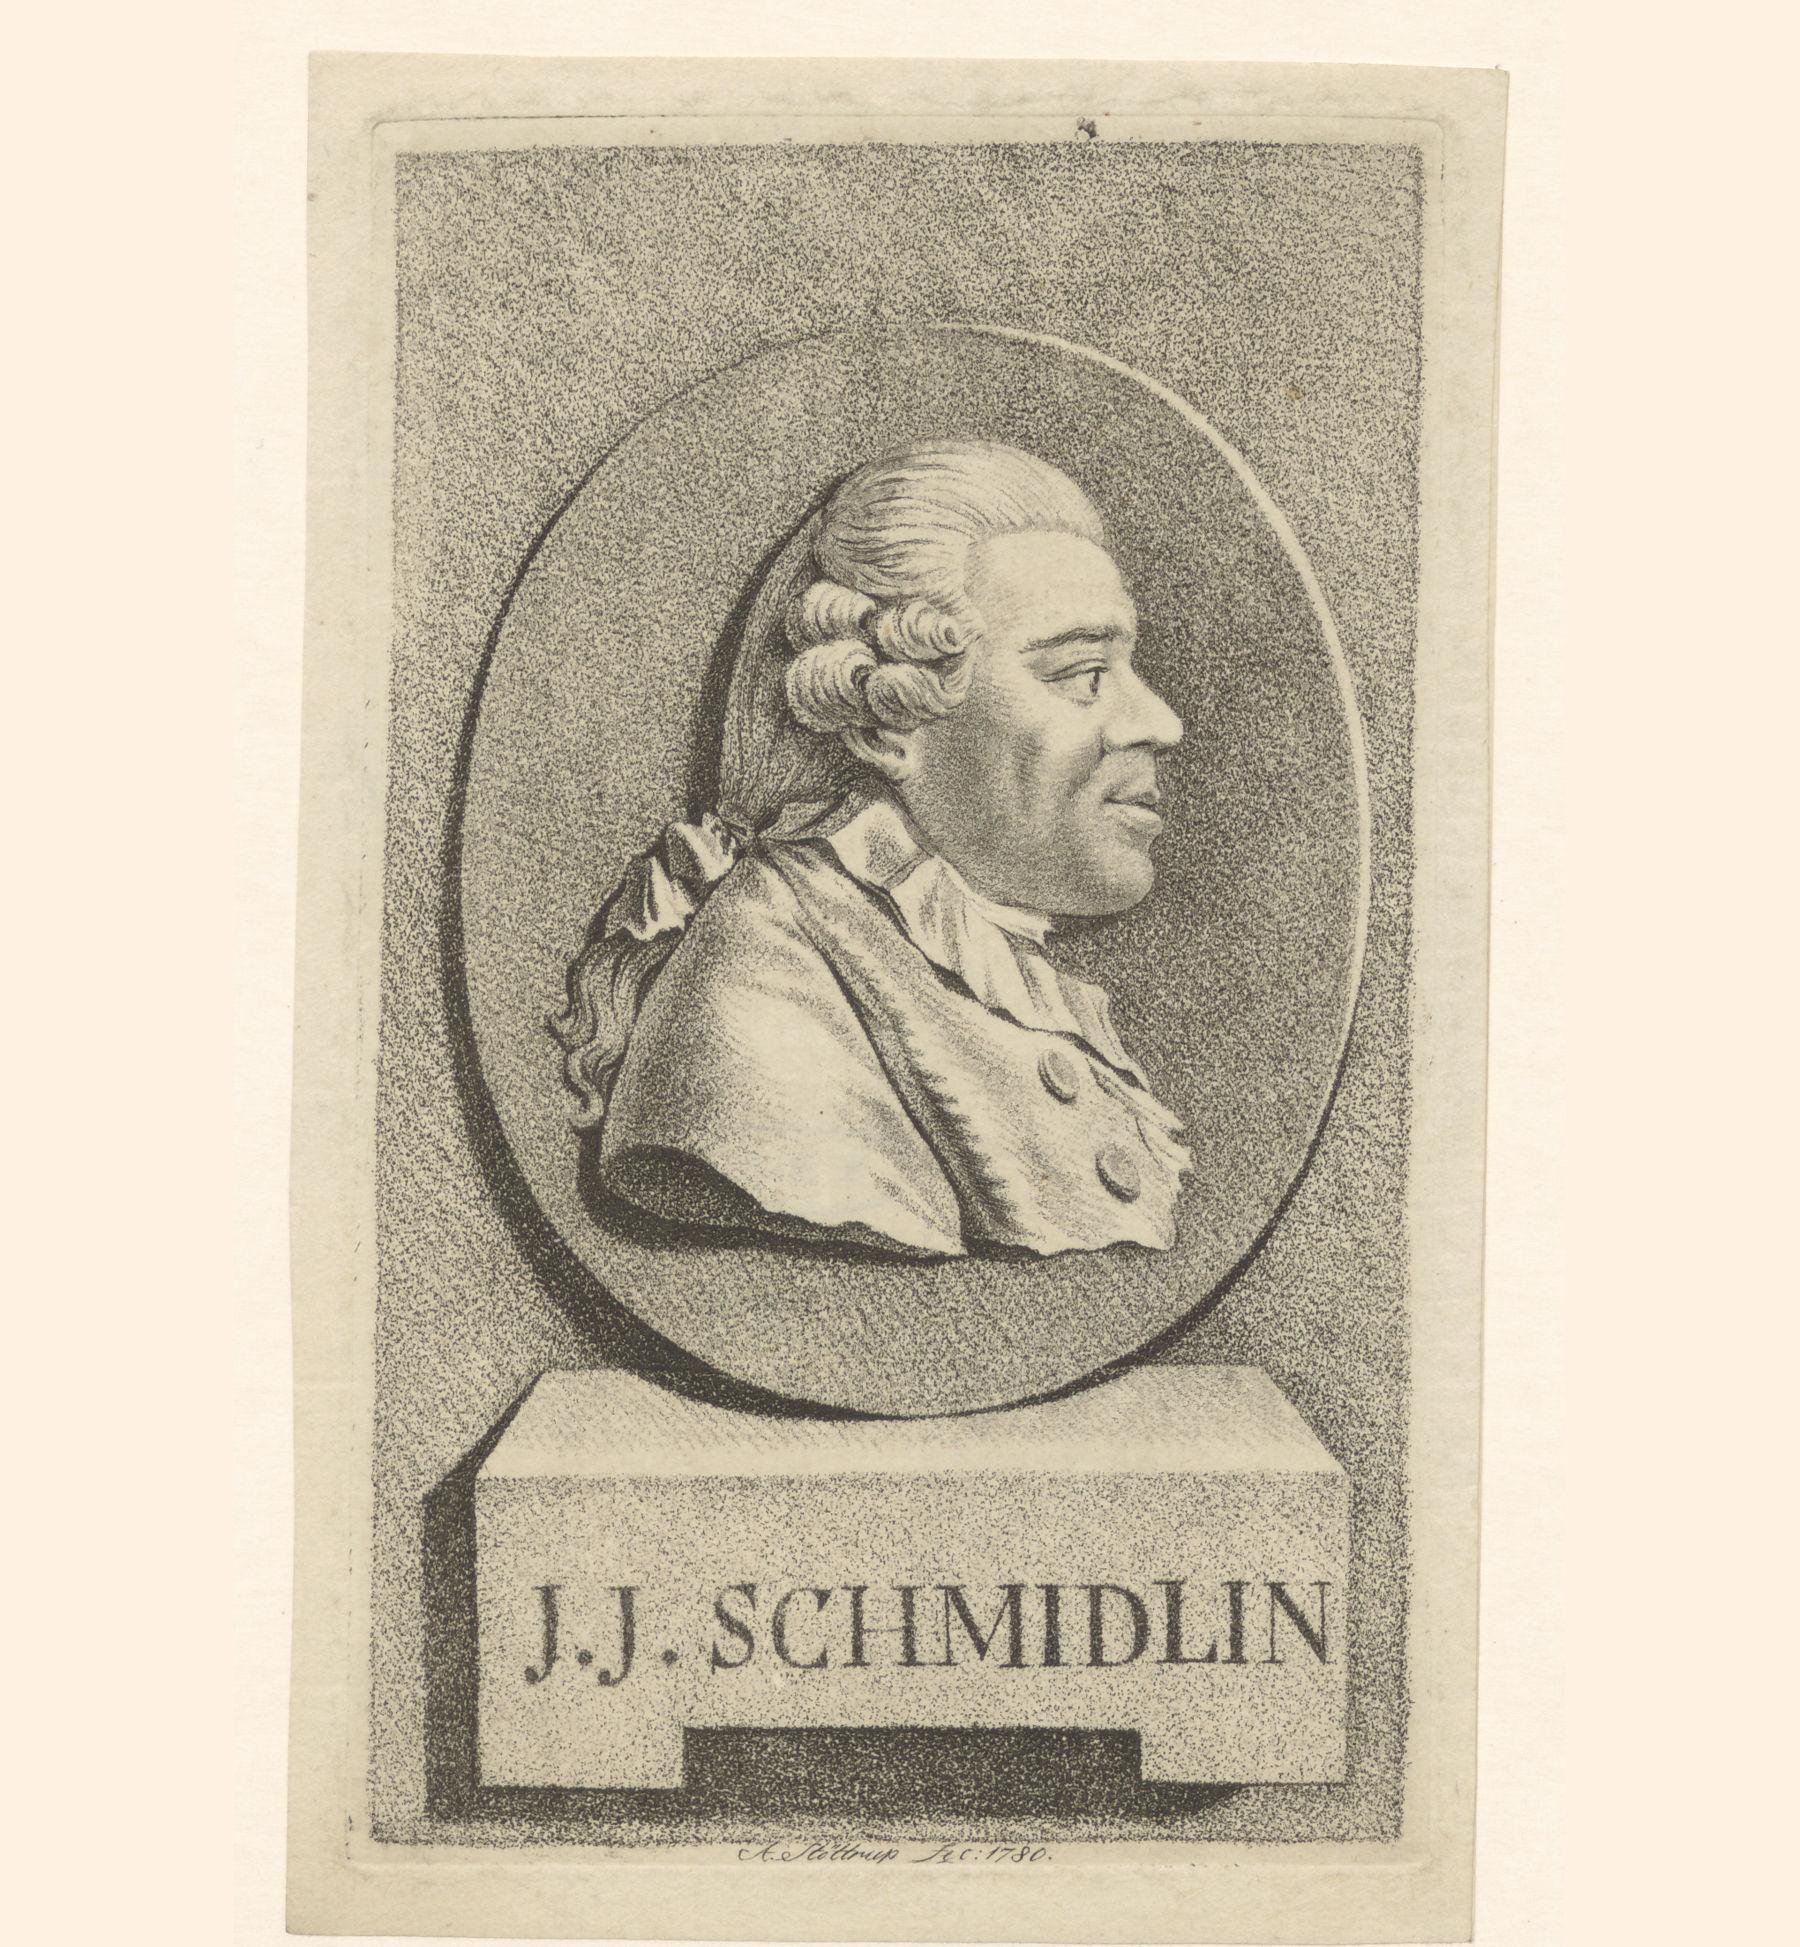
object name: print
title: Portret van Johann Josef Schmidlin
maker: andreas stöttrup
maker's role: draughtsman, painter, print maker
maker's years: 1751-1812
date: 1780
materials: paper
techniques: printmaking, etching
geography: hamburg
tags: historical persons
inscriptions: collector's mark: Lugt 2228